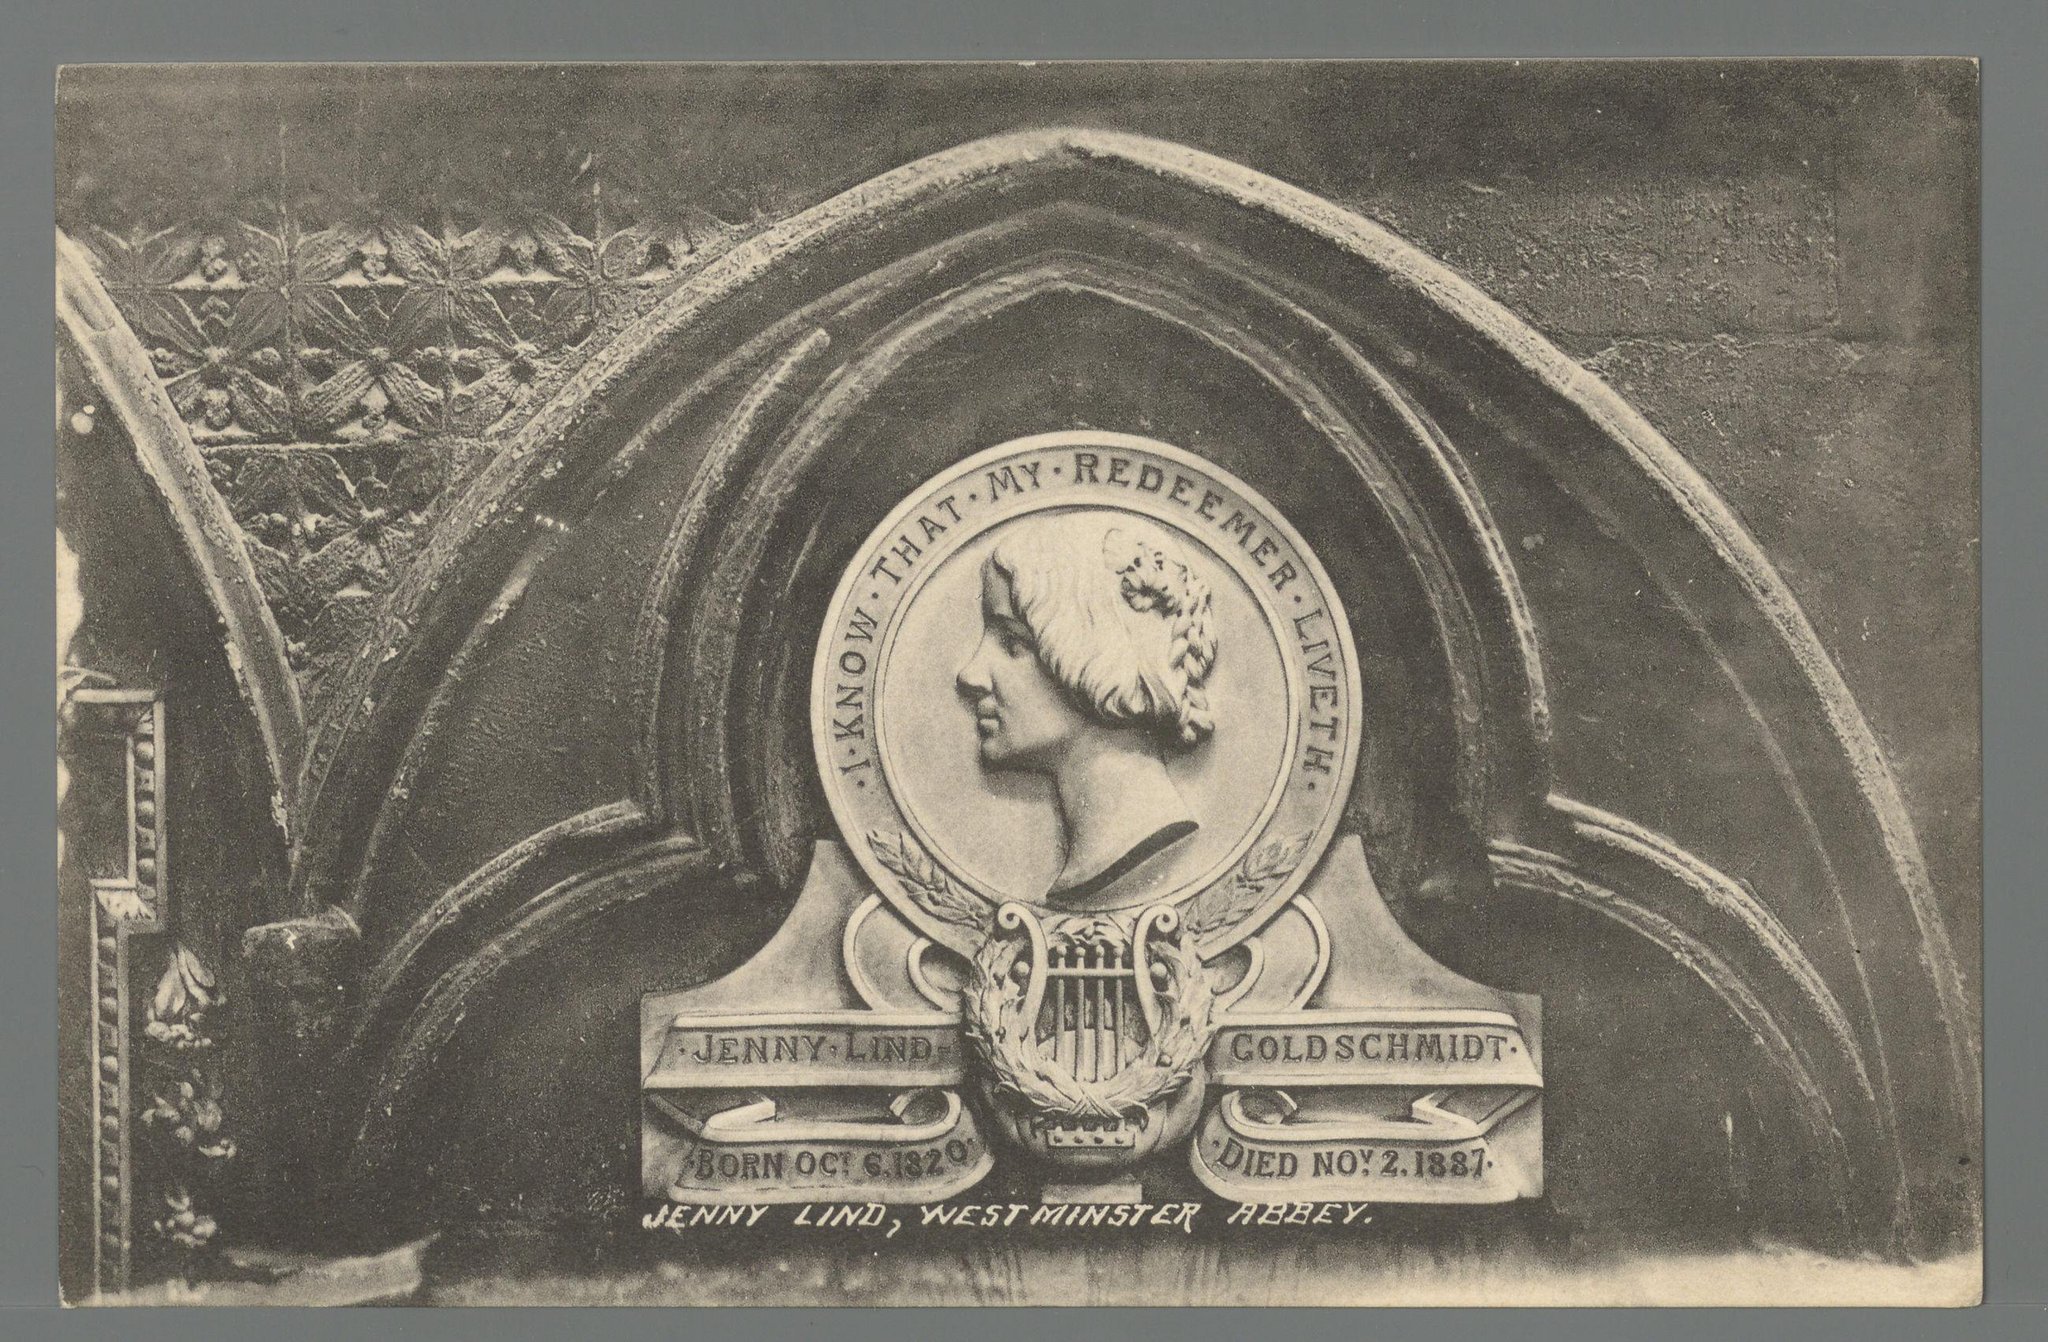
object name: ansichtkaart, prentbriefkaart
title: Jenny Lind, Westminster Abbey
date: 1902-1930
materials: cardboard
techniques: photograph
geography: great britain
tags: monument, statue, portrait of opera-singer, westminster abbey